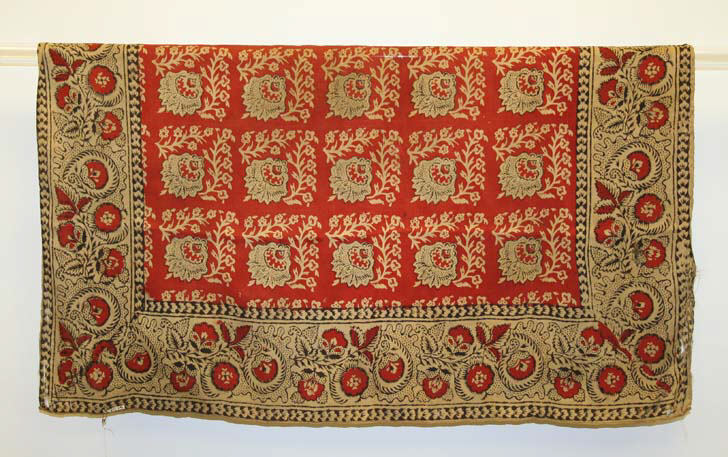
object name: kerchief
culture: american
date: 1830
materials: silk